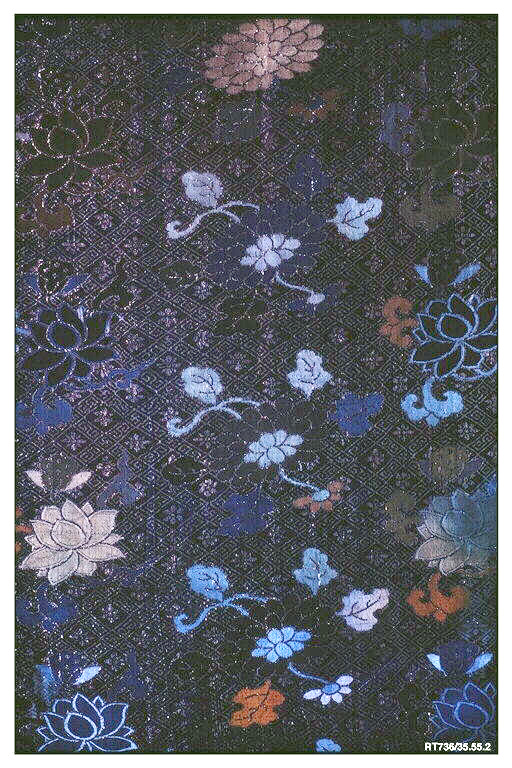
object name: piece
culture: chinese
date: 1701-1733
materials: metal thread, silk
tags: flowers